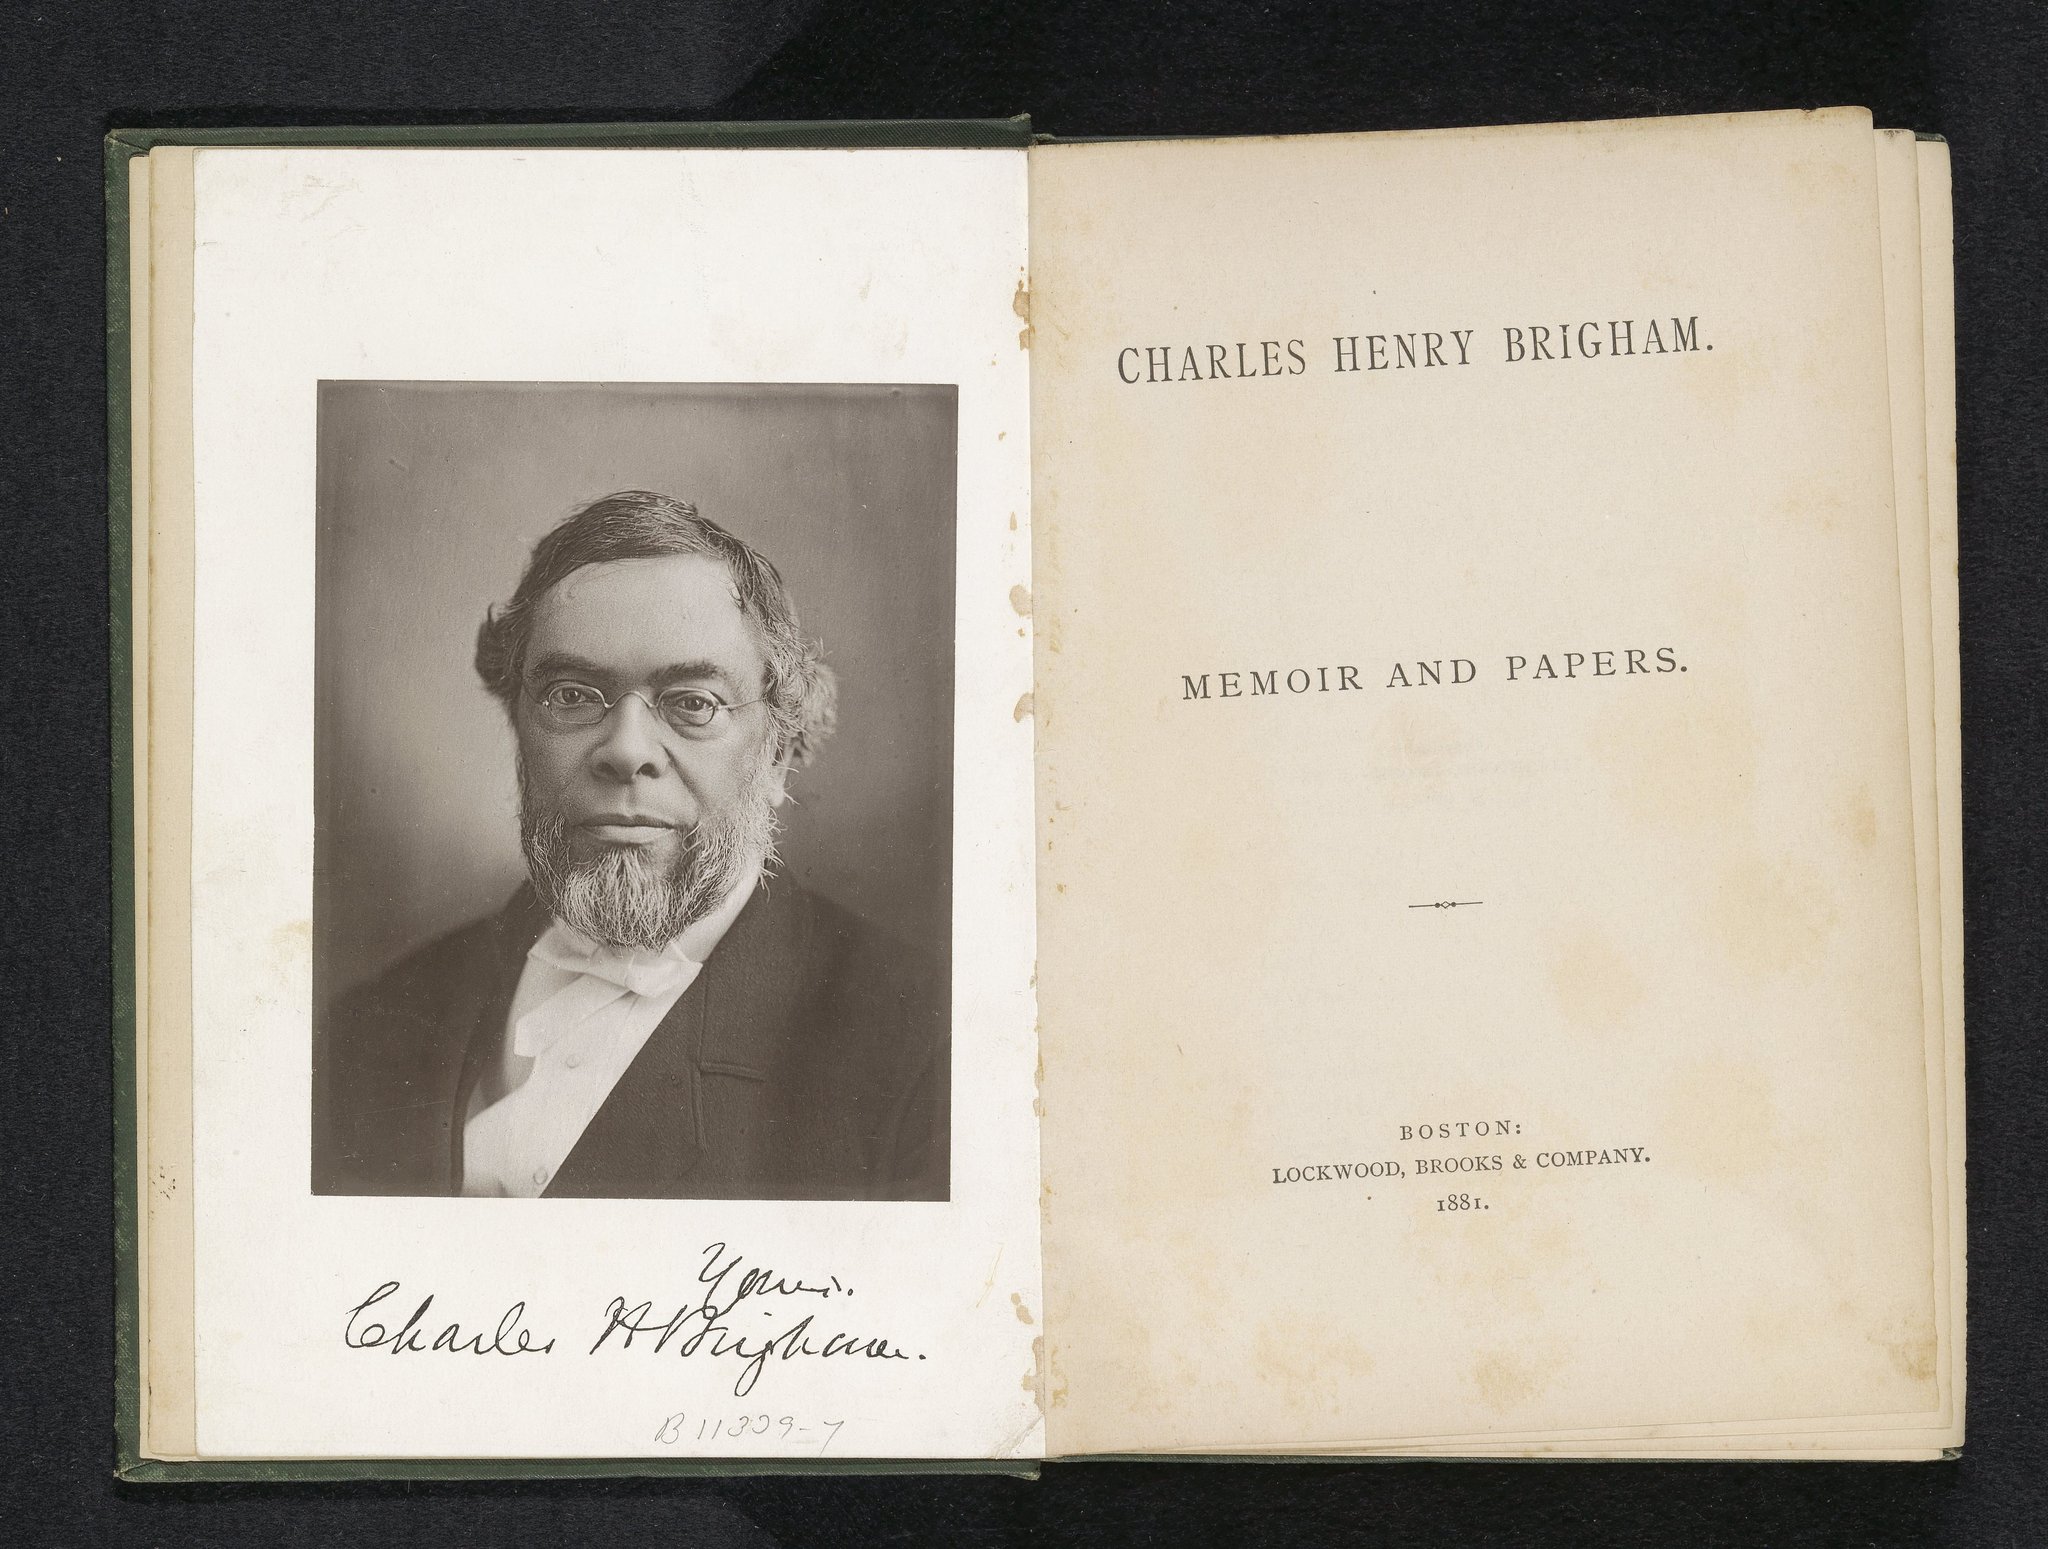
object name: book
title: Charles Henry Brigham : memoir and papers.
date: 1881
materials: cardboard, linen, paper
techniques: photograph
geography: boston